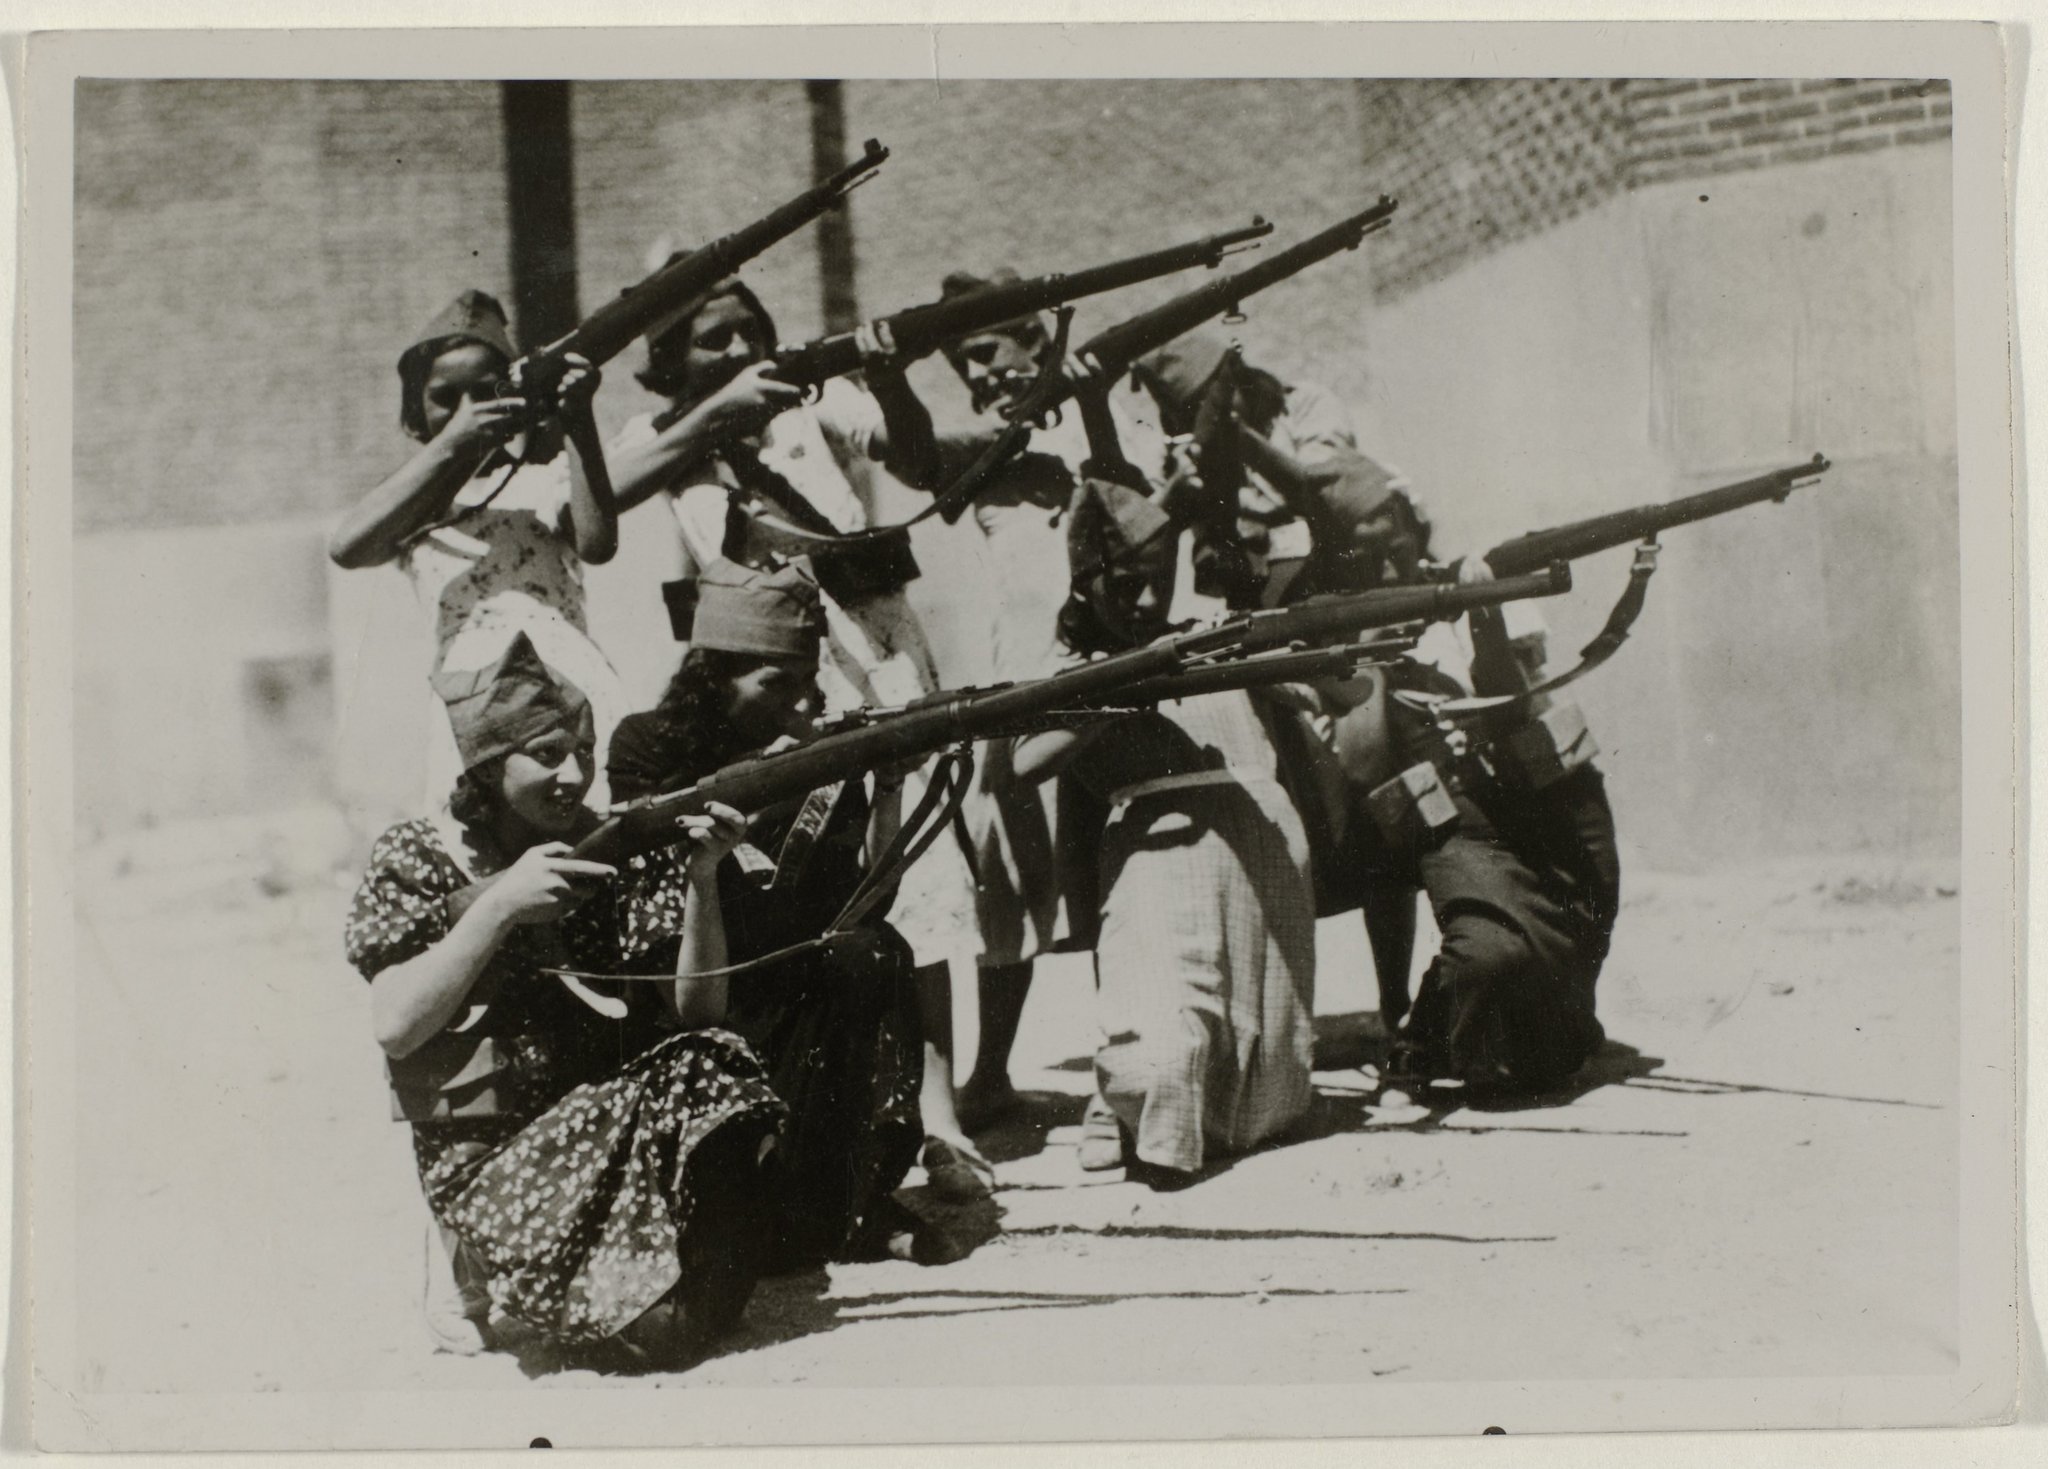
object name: news photograph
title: Les femmes dans la guerre civile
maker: Anonymous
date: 1936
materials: photographic support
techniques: gelatin silver print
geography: paris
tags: madrid, spaanse burgeroorlog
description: Een republikeins regiment van vrouwen oefent met geweren in de straten van Madrid, 3 augustus 1936 tijdens de Spaanse Burgeroorlog. Op de achterzijde een stempel en blaadje met perstekst in het Frans.